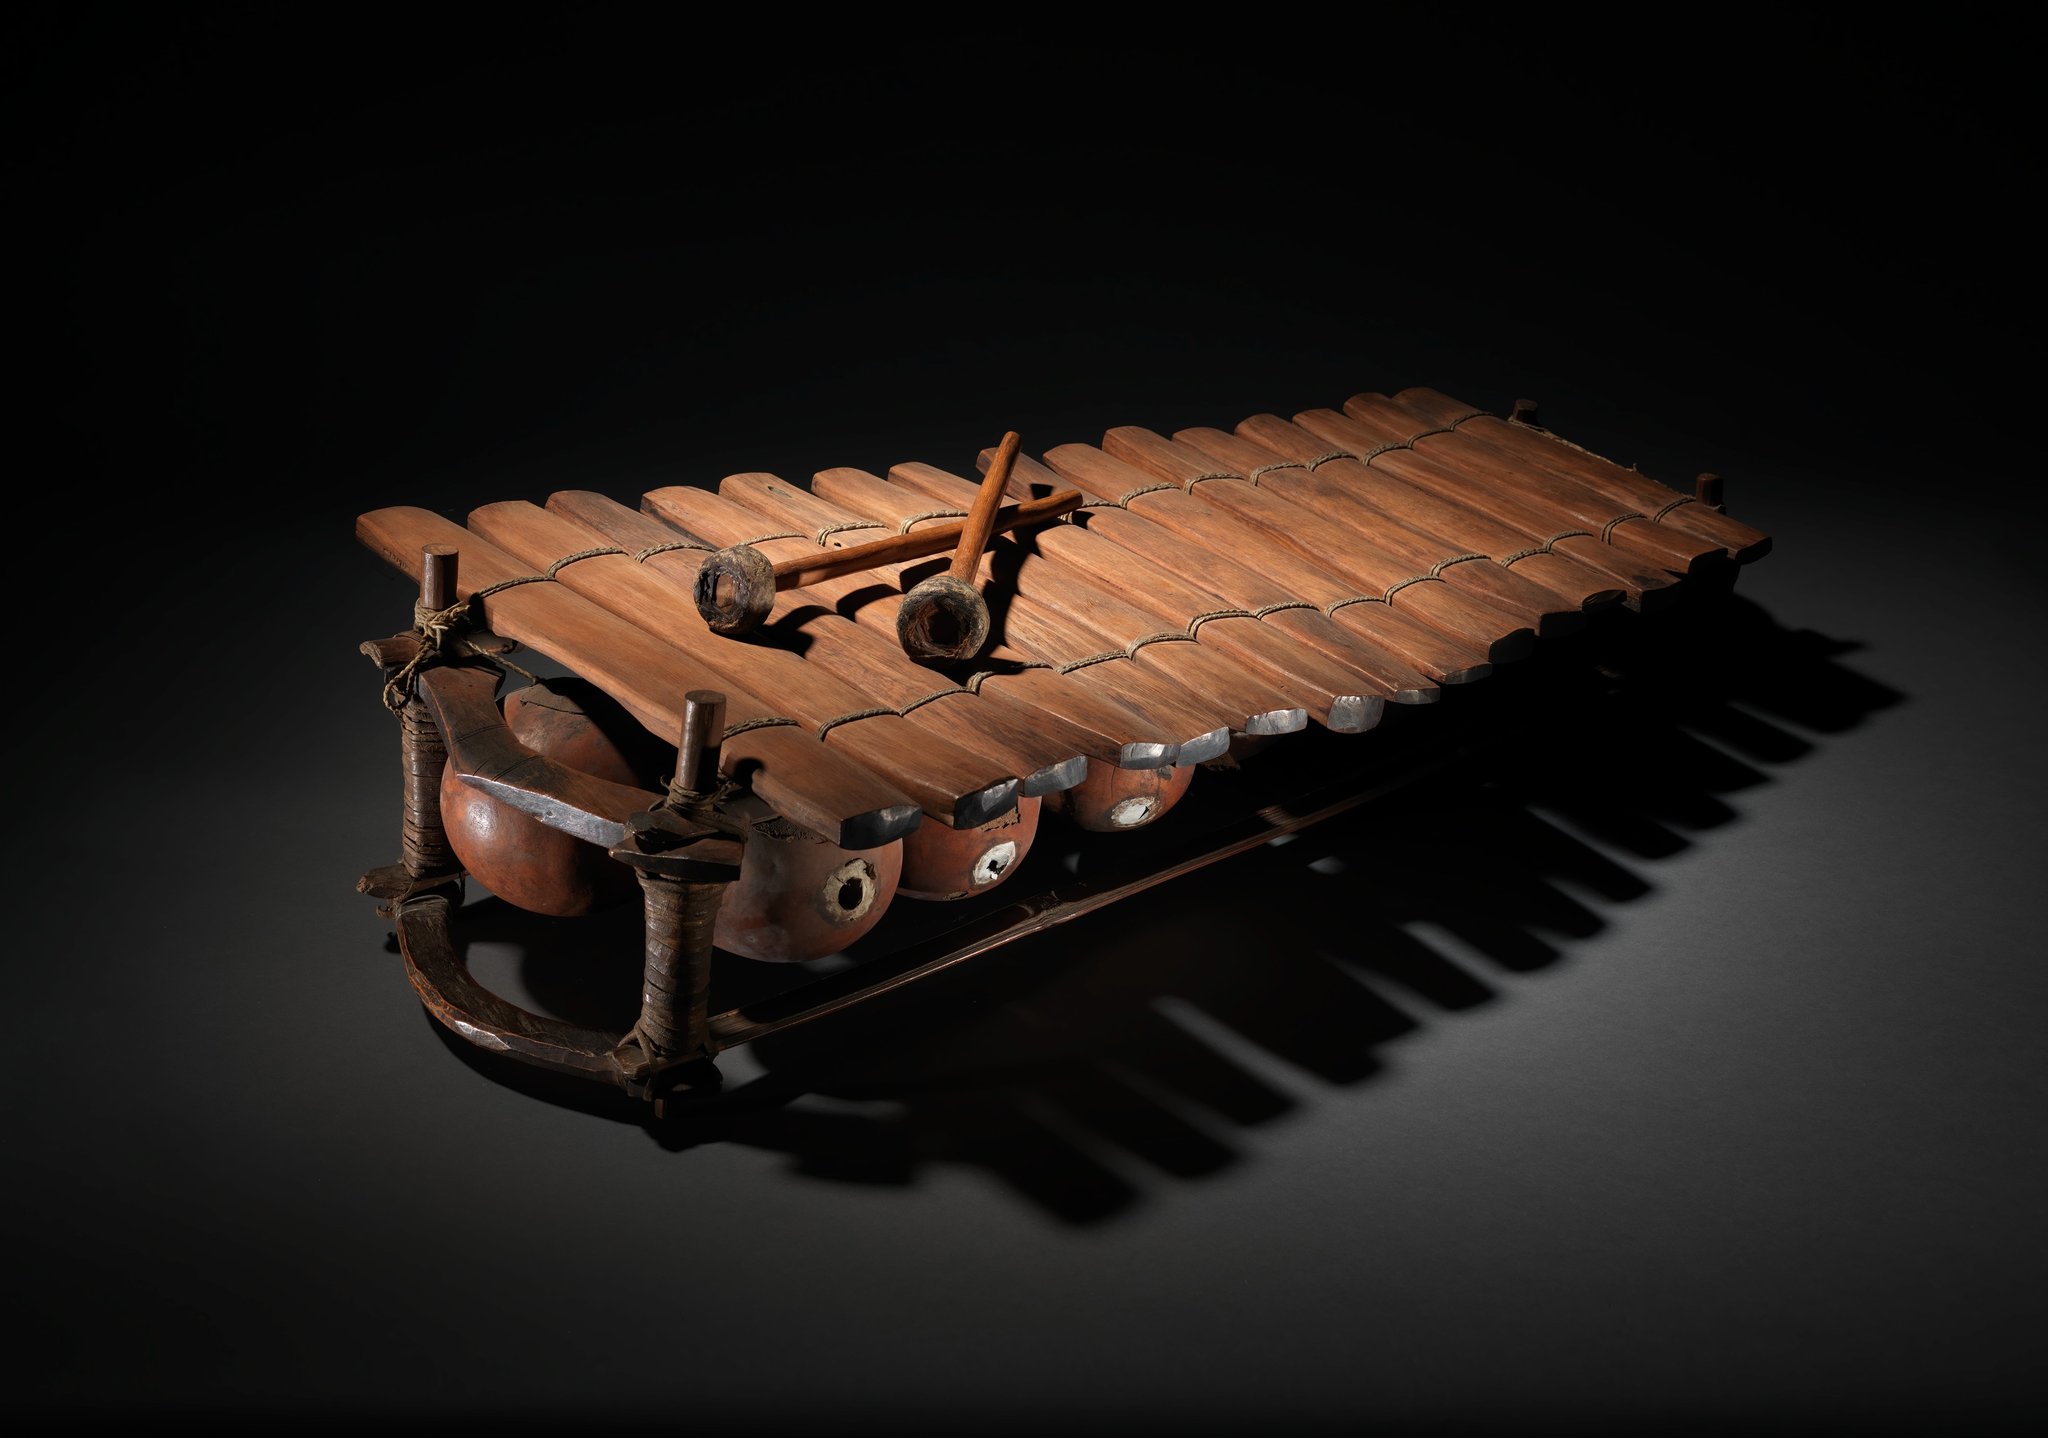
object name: bala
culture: malinke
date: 1801-1900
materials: wood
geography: mali